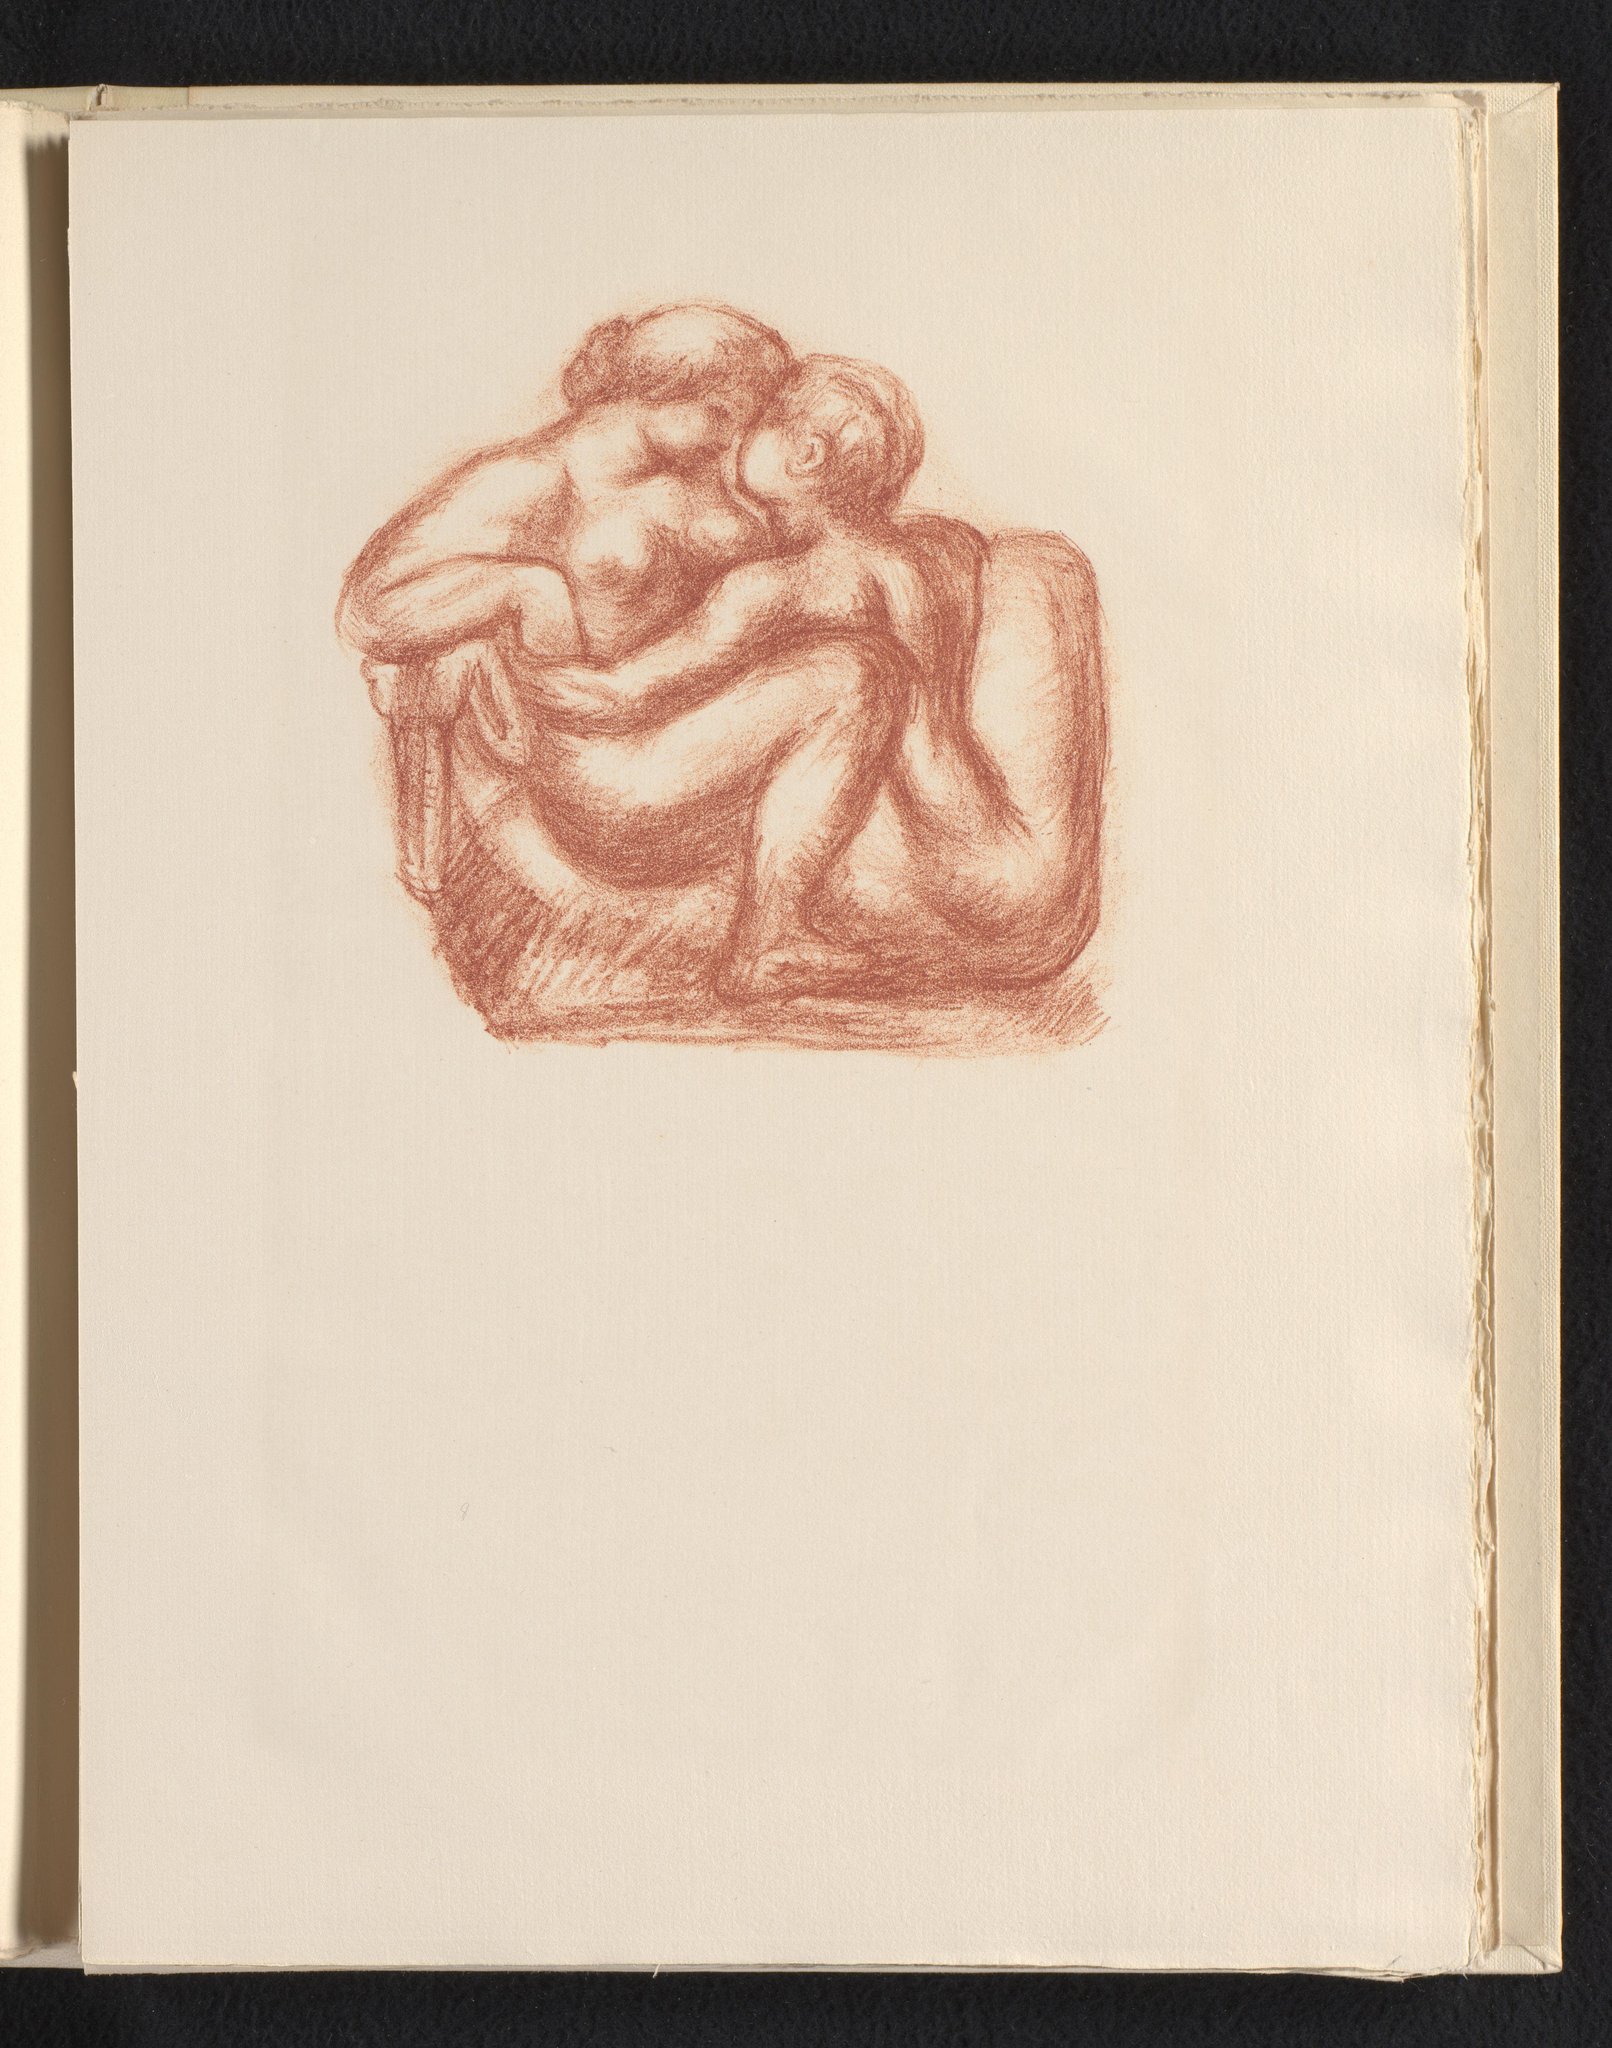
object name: page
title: Zittend naakt koppel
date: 1948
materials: paper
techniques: lithograph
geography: paris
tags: (showing oneself) undressed, quasi-nude, couple of lovers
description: Prent uit: Lucianus van Samosata. Dialogues des Courtisanes. [Vertaald uit het Grieks door] Charles Astruc. Parijs: s.n., 1948, deel van de suite met een extra afdruk van de prenten in sanguine.